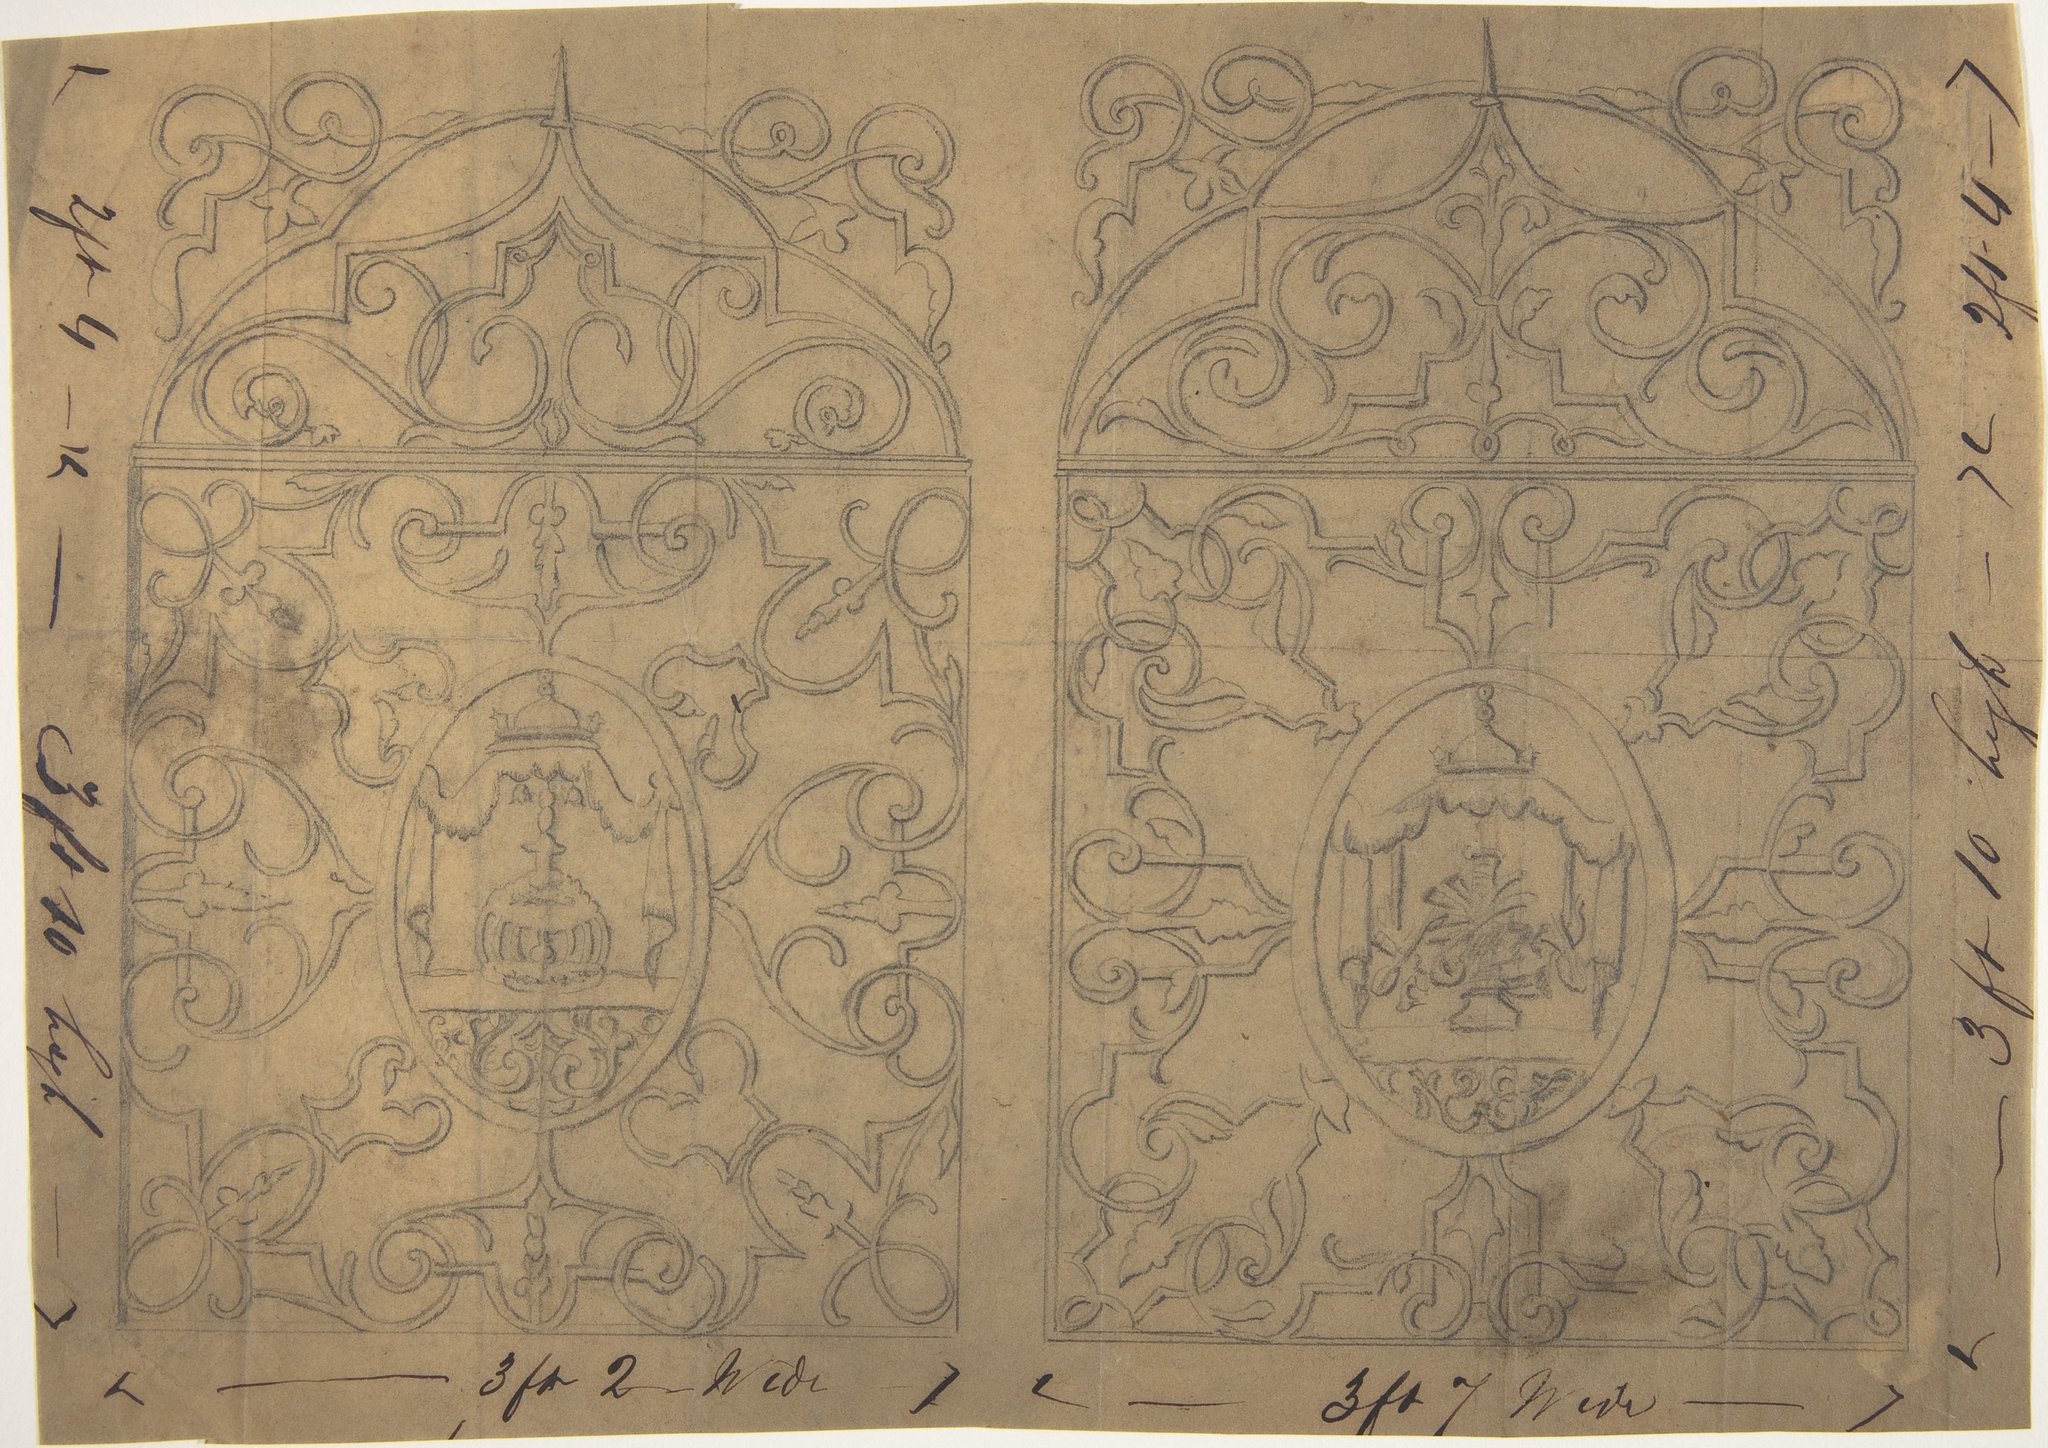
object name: drawing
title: Ornament Designs on Two Panels, the Central Cartouches Decorated with Tents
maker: richardson ellson & co.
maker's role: artist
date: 1880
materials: graphite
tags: cartouches,ornament